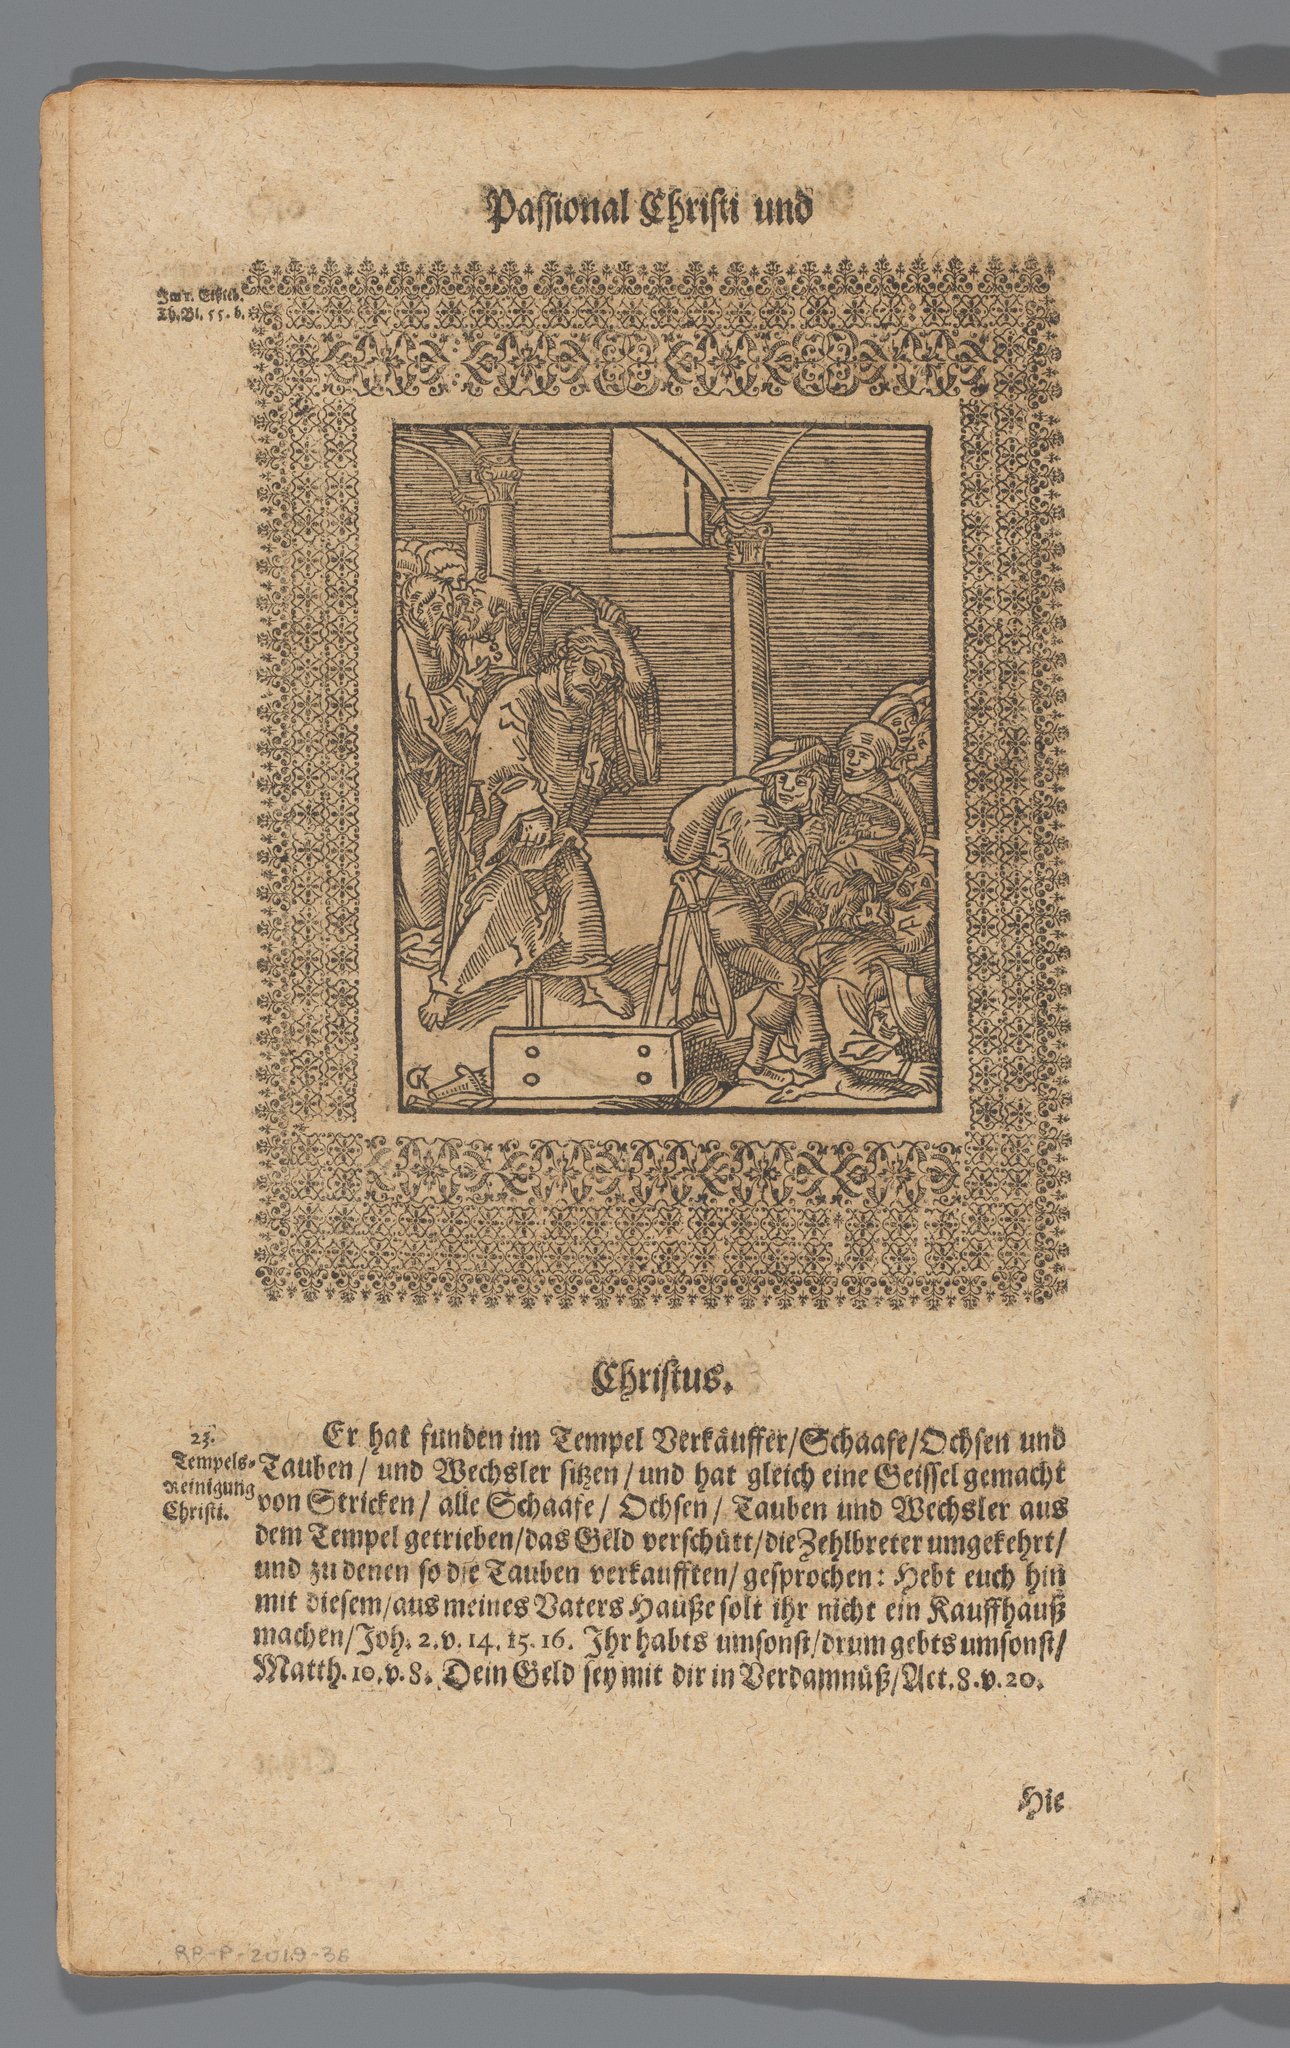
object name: print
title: Christus verdrijft de geldwisselaars uit de tempel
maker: monogrammist gk (prentmaker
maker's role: print maker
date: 1661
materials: paper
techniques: letterpress printing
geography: europe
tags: the richness of the church opposed to christ's humility, purification of the temple ('first' and 'second'): christ driving the money-changers from the temple with a whip (matthew 21:12-13; mark 11:15-17; luke 19:45-46; john 12:12-19)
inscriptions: collector's mark: Lugt 2228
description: Christus verdrijft de geldwisselaars uit de tempel. Tegenstelling over geld en religie. Spiegelbeeldige kopie naar de prent van Lucas Cranach in het pamflet 'Passional Christi und Antichristi' van Martin Luther uit 1521, bladzijde uit een 17e-eeuwse uitgave. De reeks van dertien paar houtsneden geeft de tegenstellingen weer tussen de nederigheid en onbaatzuchtigheid van Christus enerzijds, en de trots en hebzucht van de paus anderzijds.